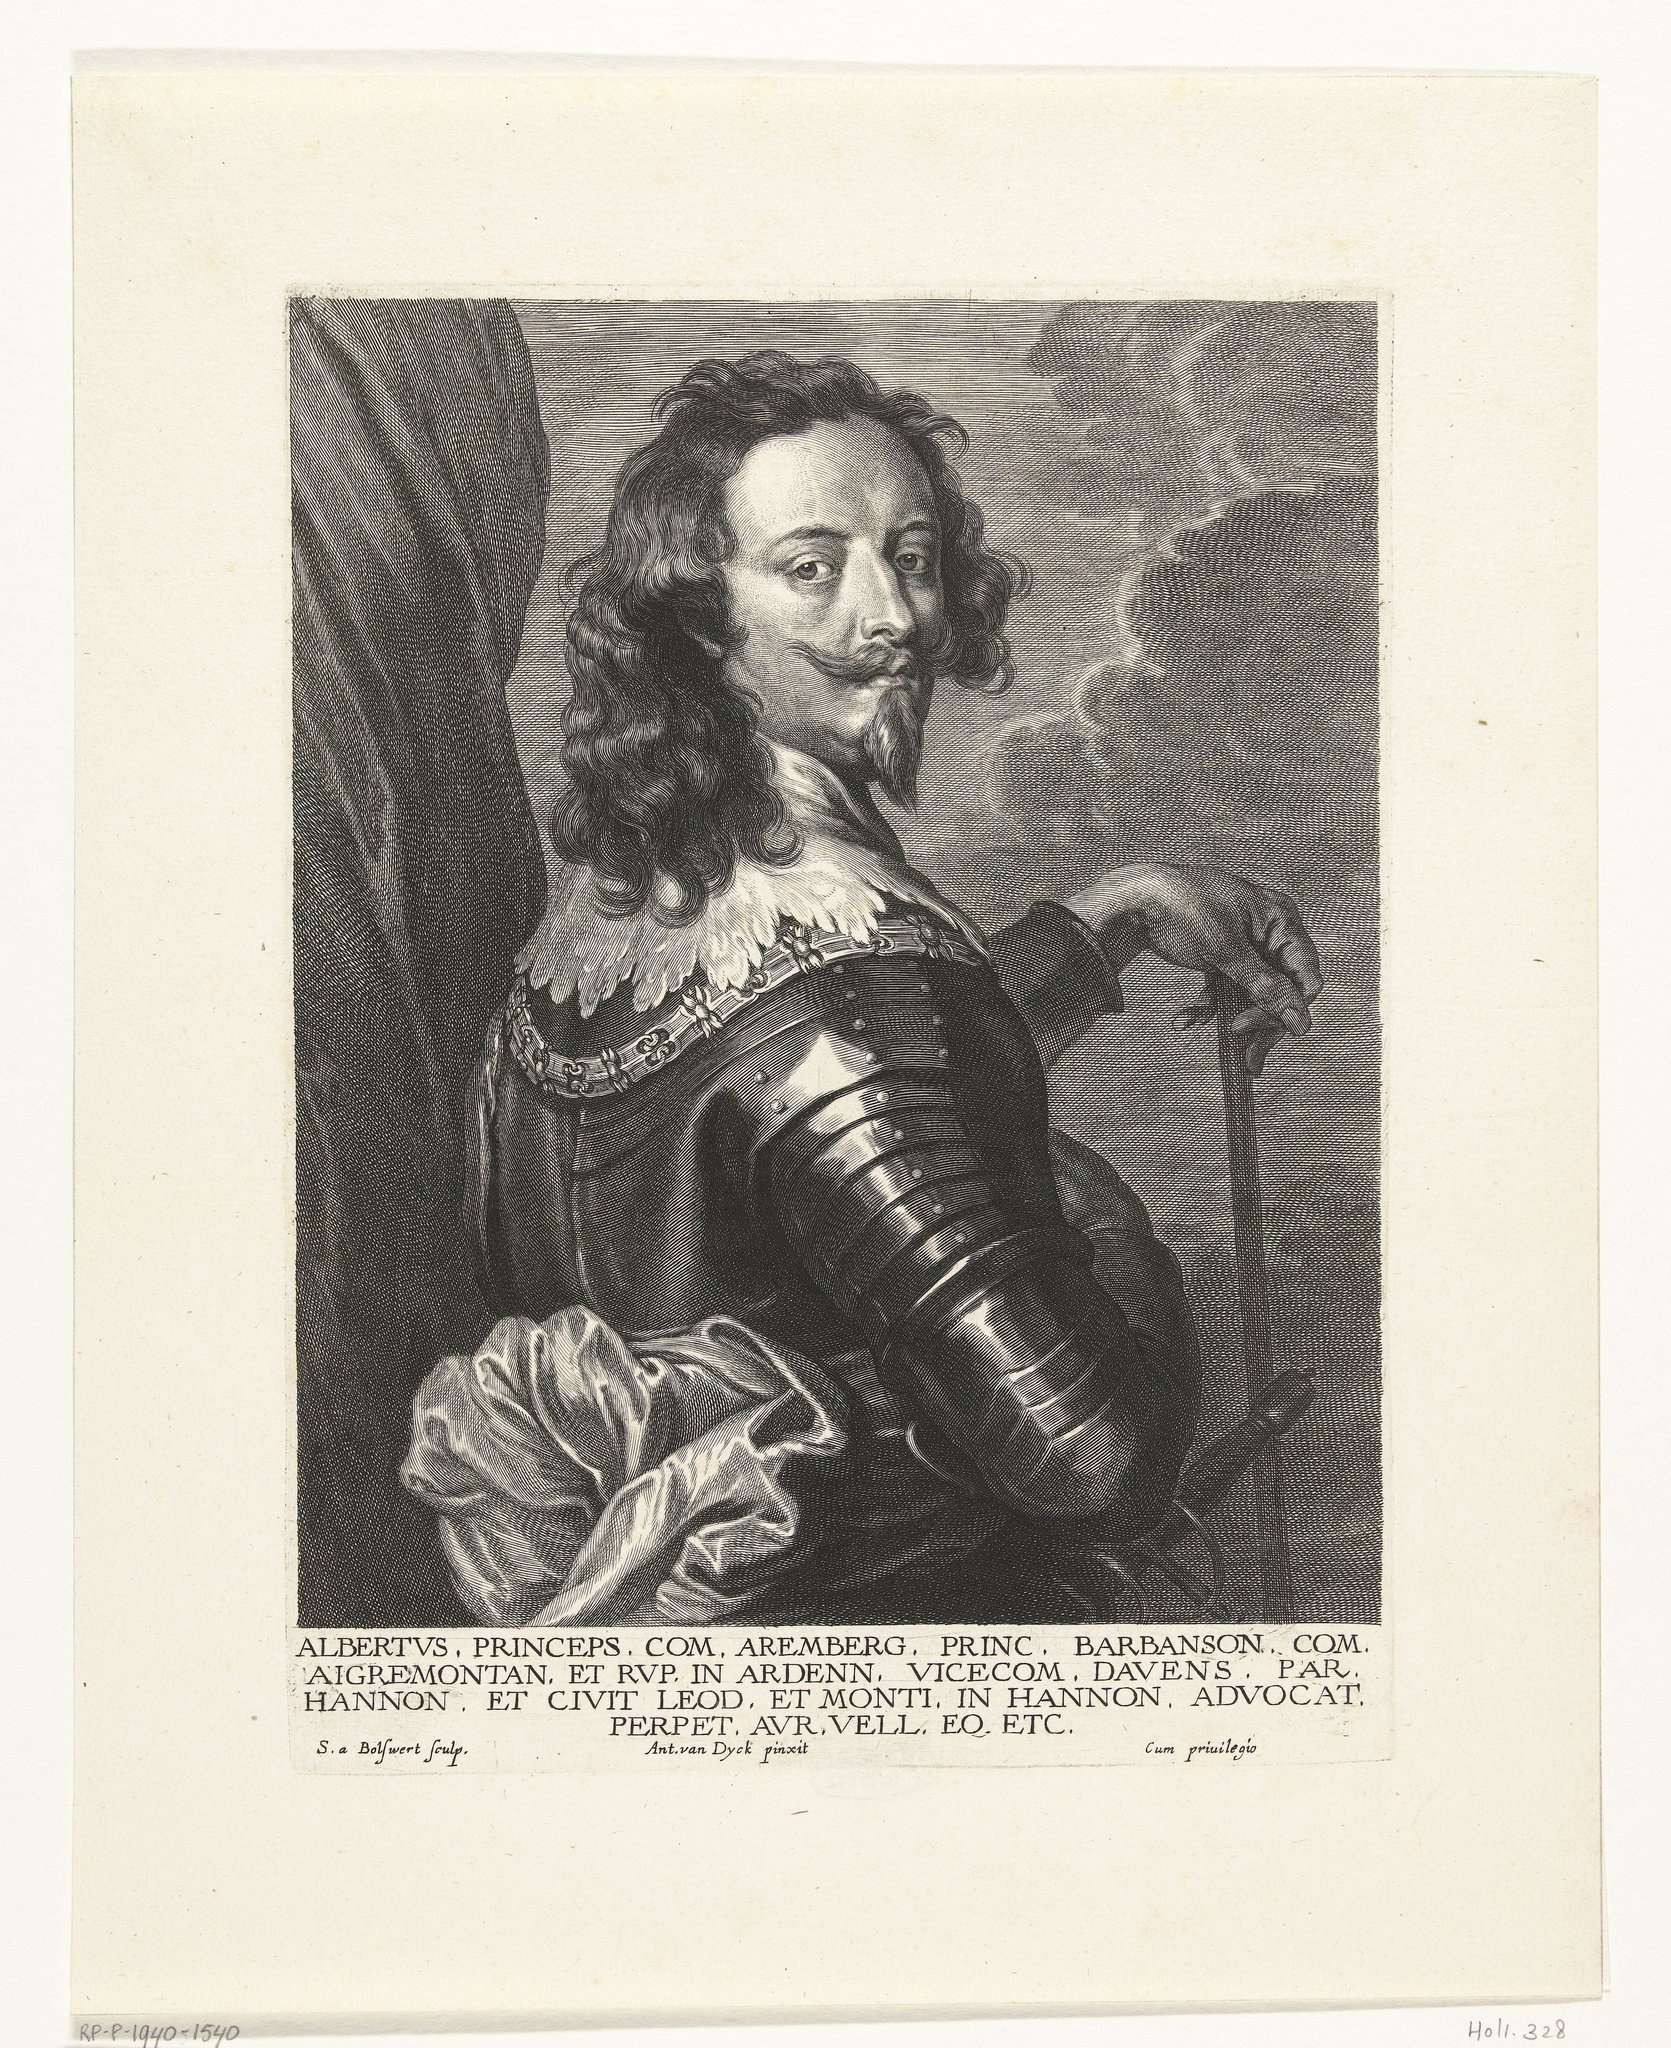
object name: print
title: Albertvs. princeps. com. (...) vell. eq etc.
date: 1627-1659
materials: paper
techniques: engraving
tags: albert de ligne (prins van barbançon en arenberg)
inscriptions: collector's mark: Lugt 2760, collector's mark: Lugt 2228, collector's mark: Lugt 2166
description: Prent naar schilderij van Anthony van Dyck dat zich bevindt in Holkham Hall, Norfolk. Het portret moet van na 1627 dateren want in dat jaar werd de graaf ridder in de Orde van het Gulden Vlies, over zijn harnas draagt hij het keten van de orde. Behoort tot de Verzameling Gerritsen, kunstenaarsportretten